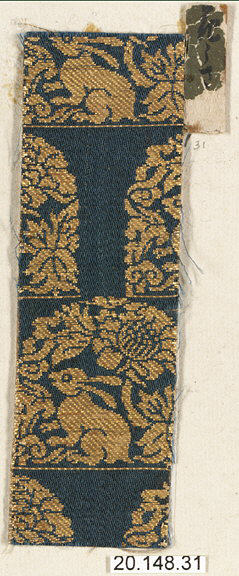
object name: piece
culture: chinese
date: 1567-1600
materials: silk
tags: rabbits,flowers